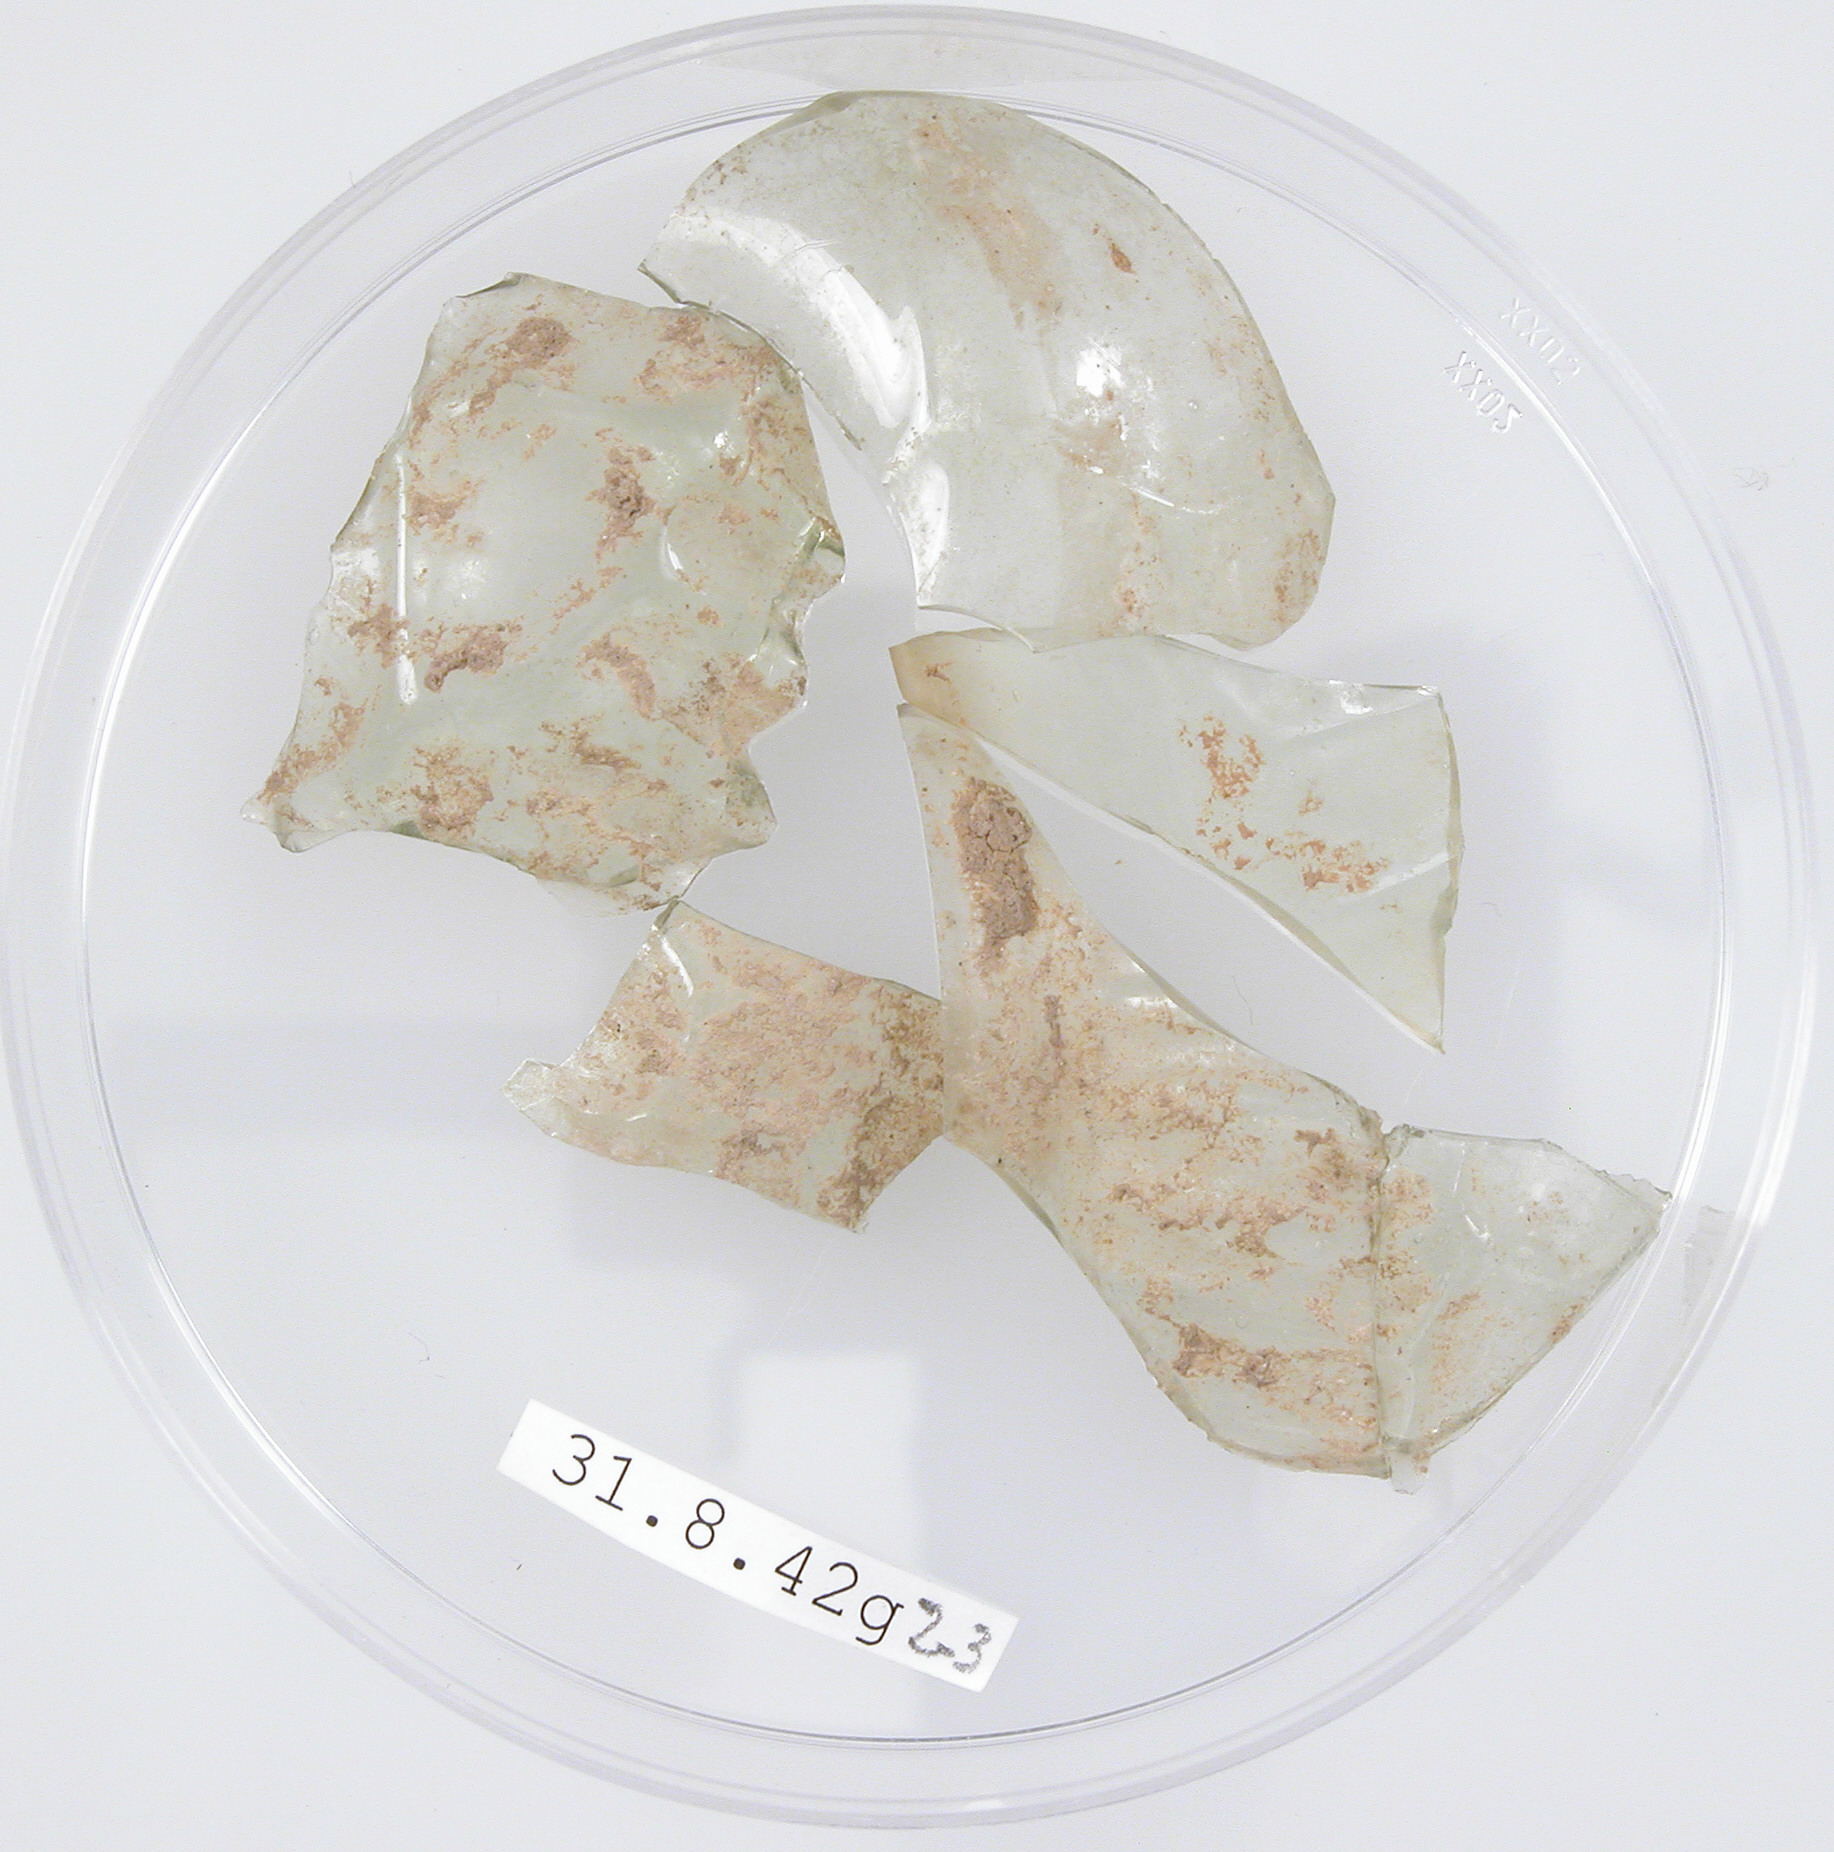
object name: fragment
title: Glass Fragments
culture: coptic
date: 301-400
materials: glass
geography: egypt